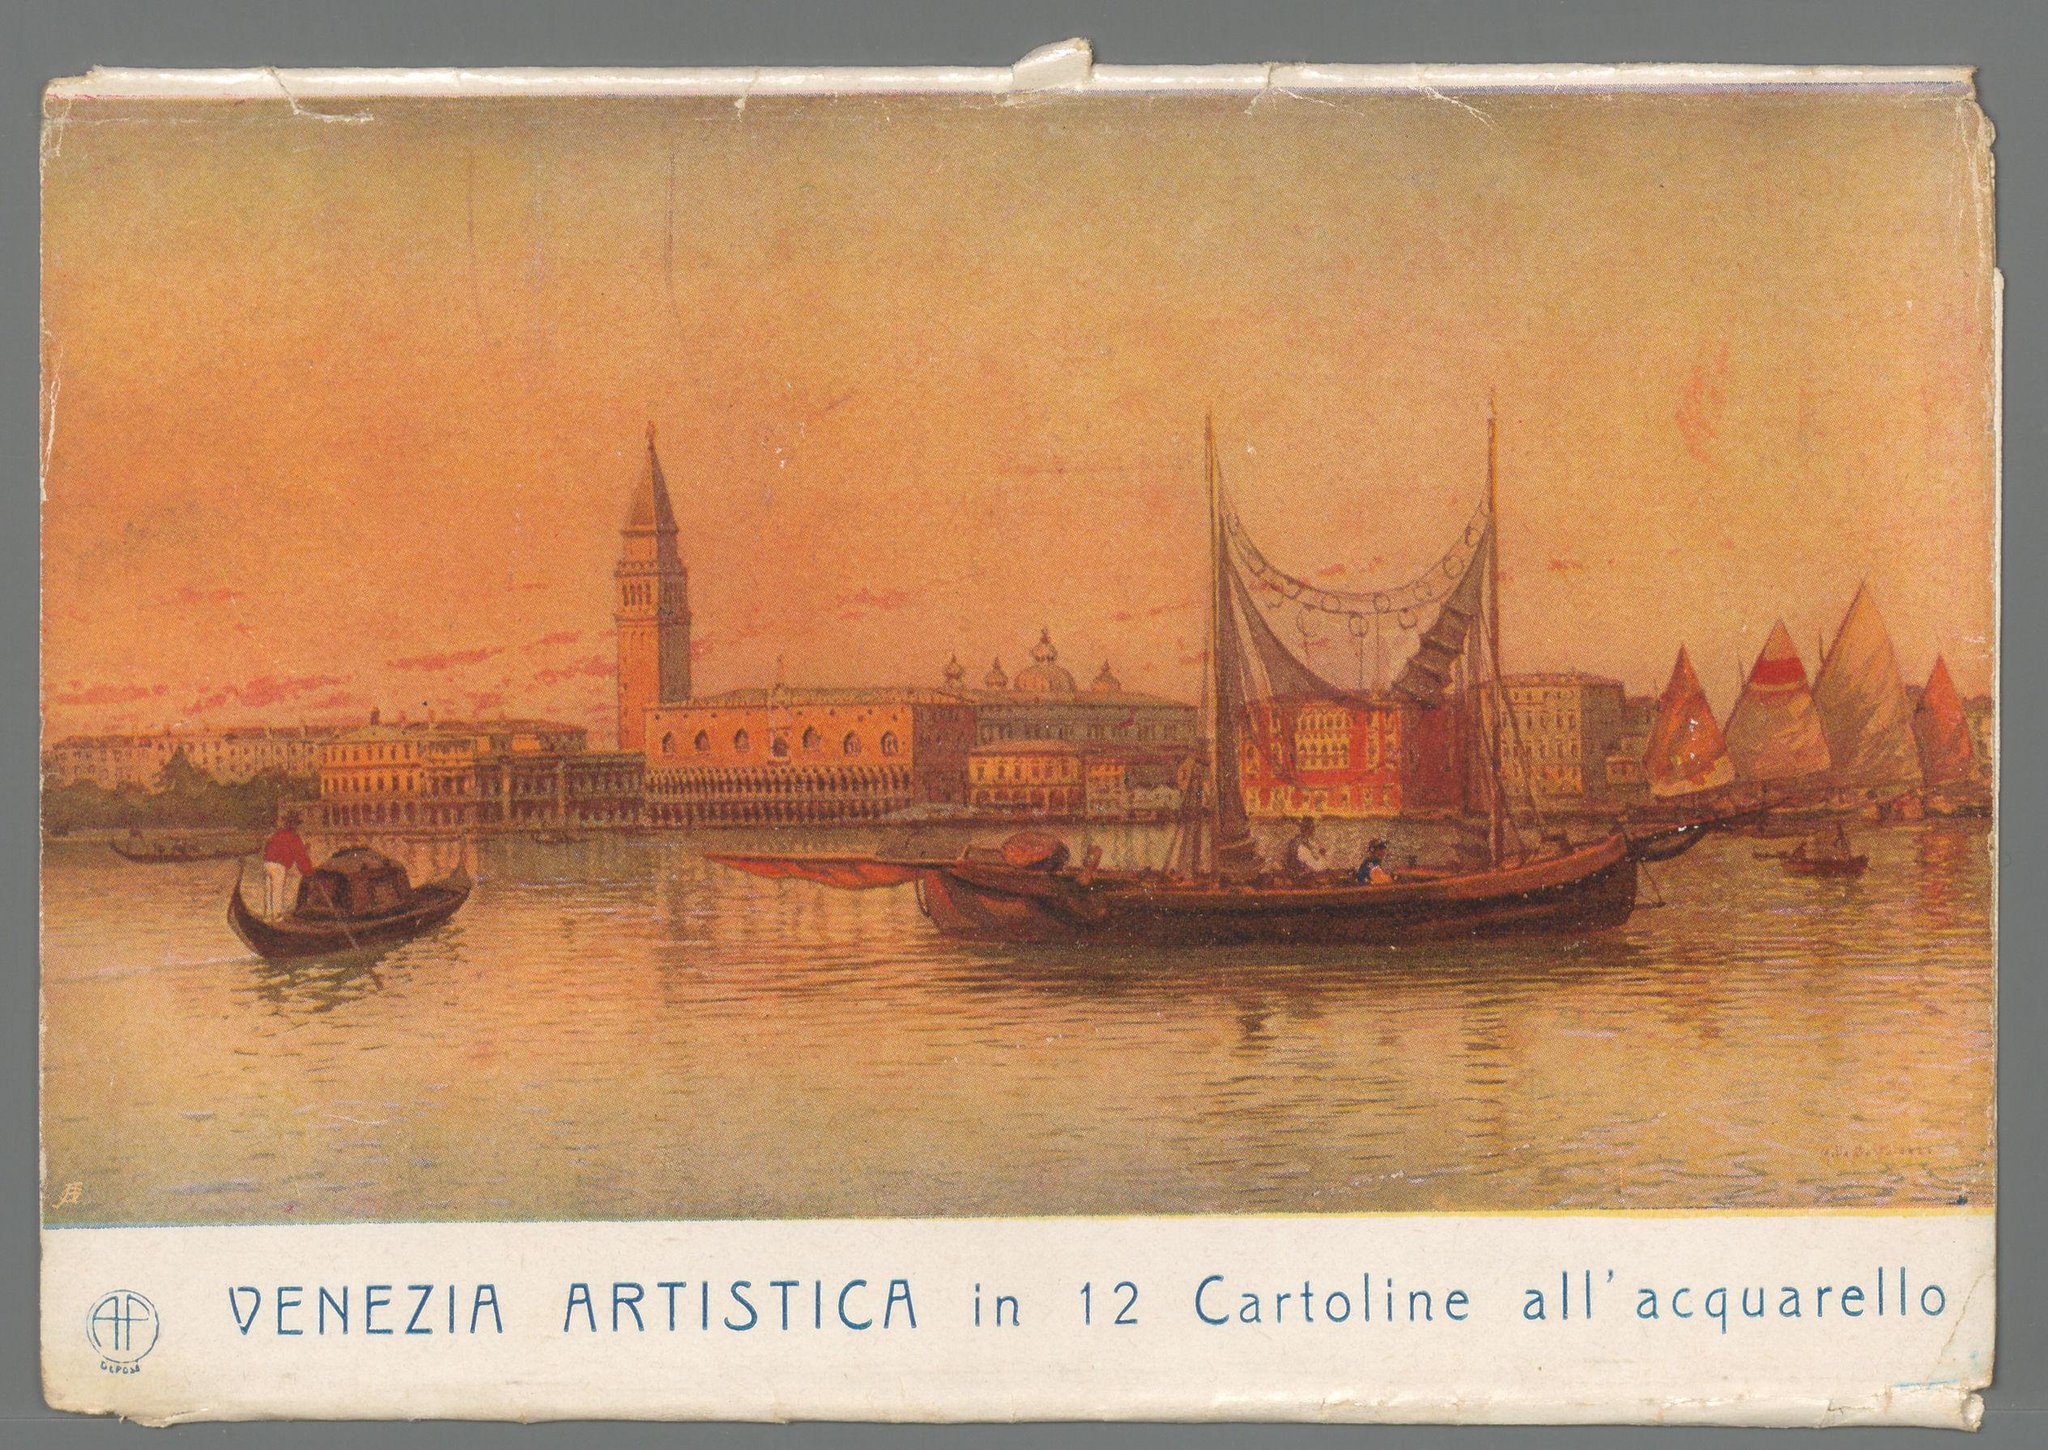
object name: wrapper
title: Omslag voor acht prentbriefkaarten van Venetië, Zuid-Tirol en Beieren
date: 1900-1950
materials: paper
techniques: letterpress printing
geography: italy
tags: city-view in general; 'veduta', ships (in general), venice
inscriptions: stamp: ‘Alla Tavolozza di Tiziano. Requisiti per Pittori (...)’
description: De acht prentbriefkaarten die in het omslag zijn aangetroffen horen niet bij dit omslag.